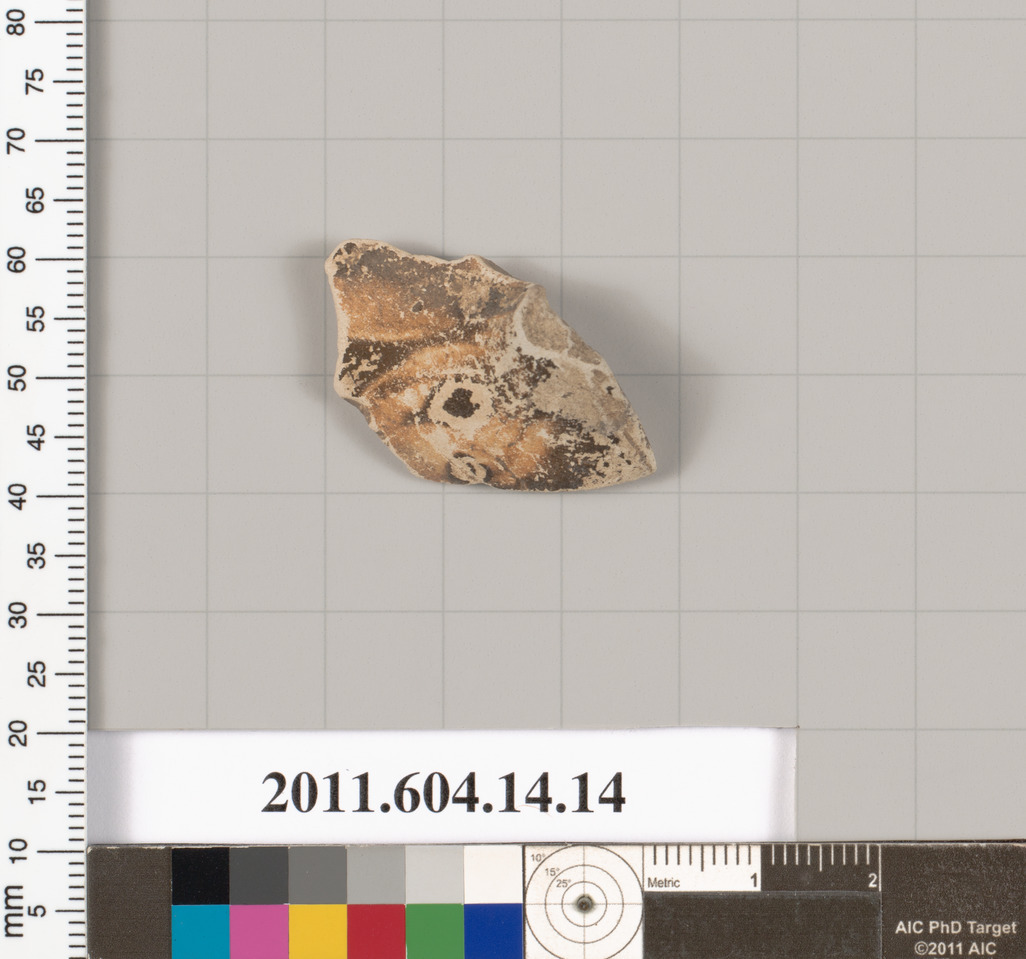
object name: undetermined shape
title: Terracotta fragment of an undetermined shape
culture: unknown fabric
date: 600-501 BCE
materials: terracotta